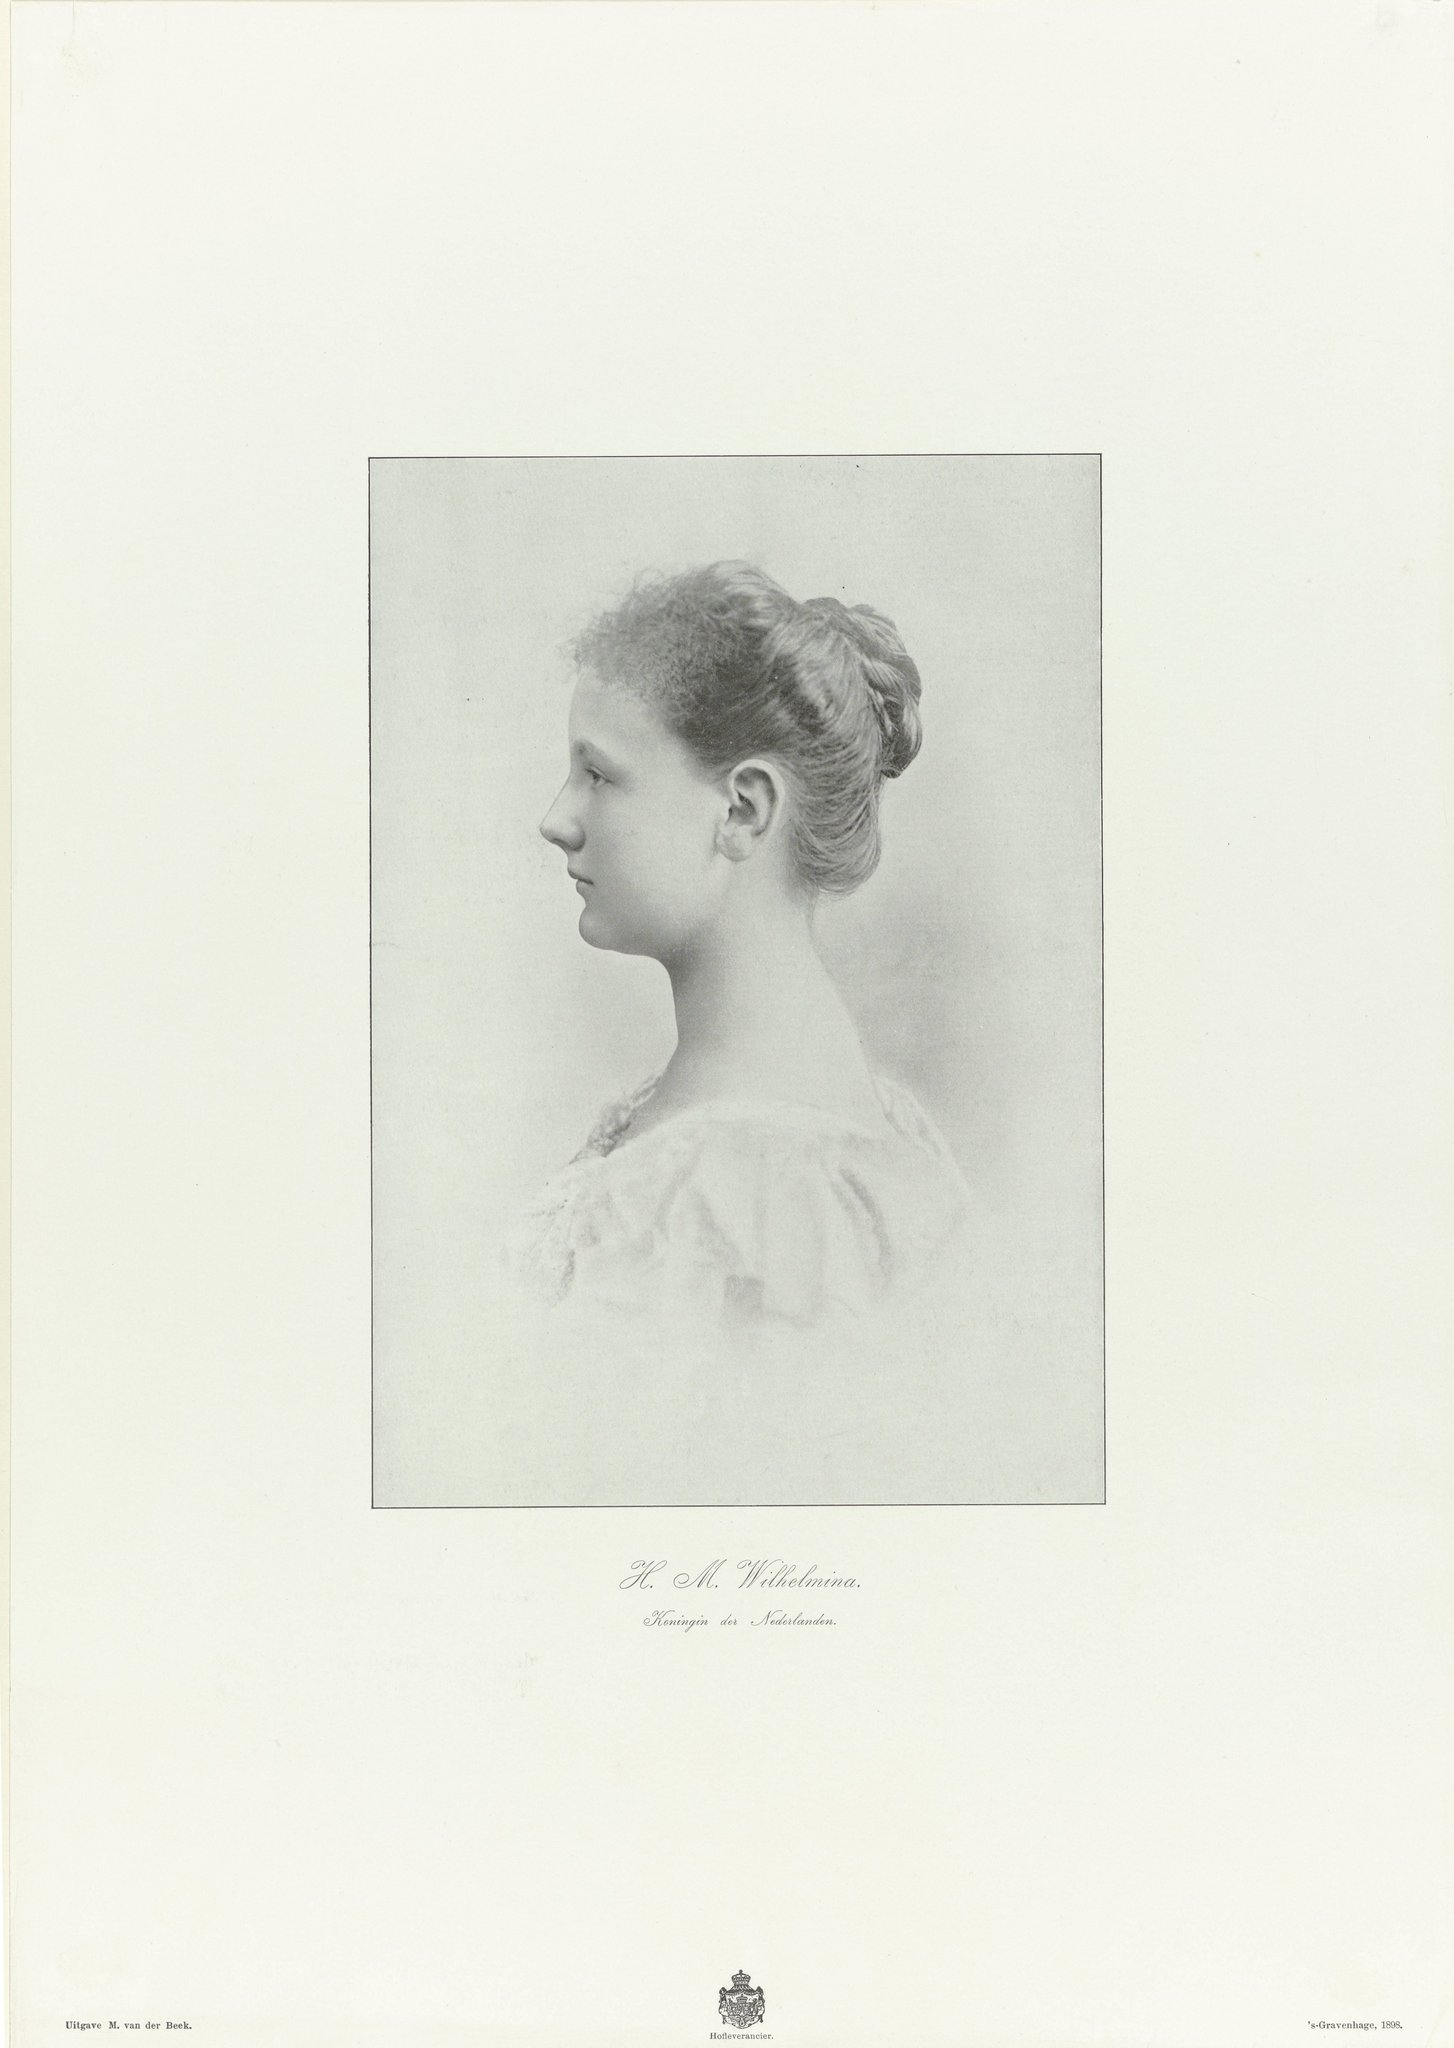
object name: photomechanical print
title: Portret van Wilhelmina, koningin der Nederlanden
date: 1898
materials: paper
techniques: autotype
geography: netherlands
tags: wilhelmina of the netherlands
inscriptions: date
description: De hier vermelde titel verwijst naar de hoogst verkregen titel van de geportretteerde, niet per se naar de titel die de geportretteerde op deze voorstelling draagt.